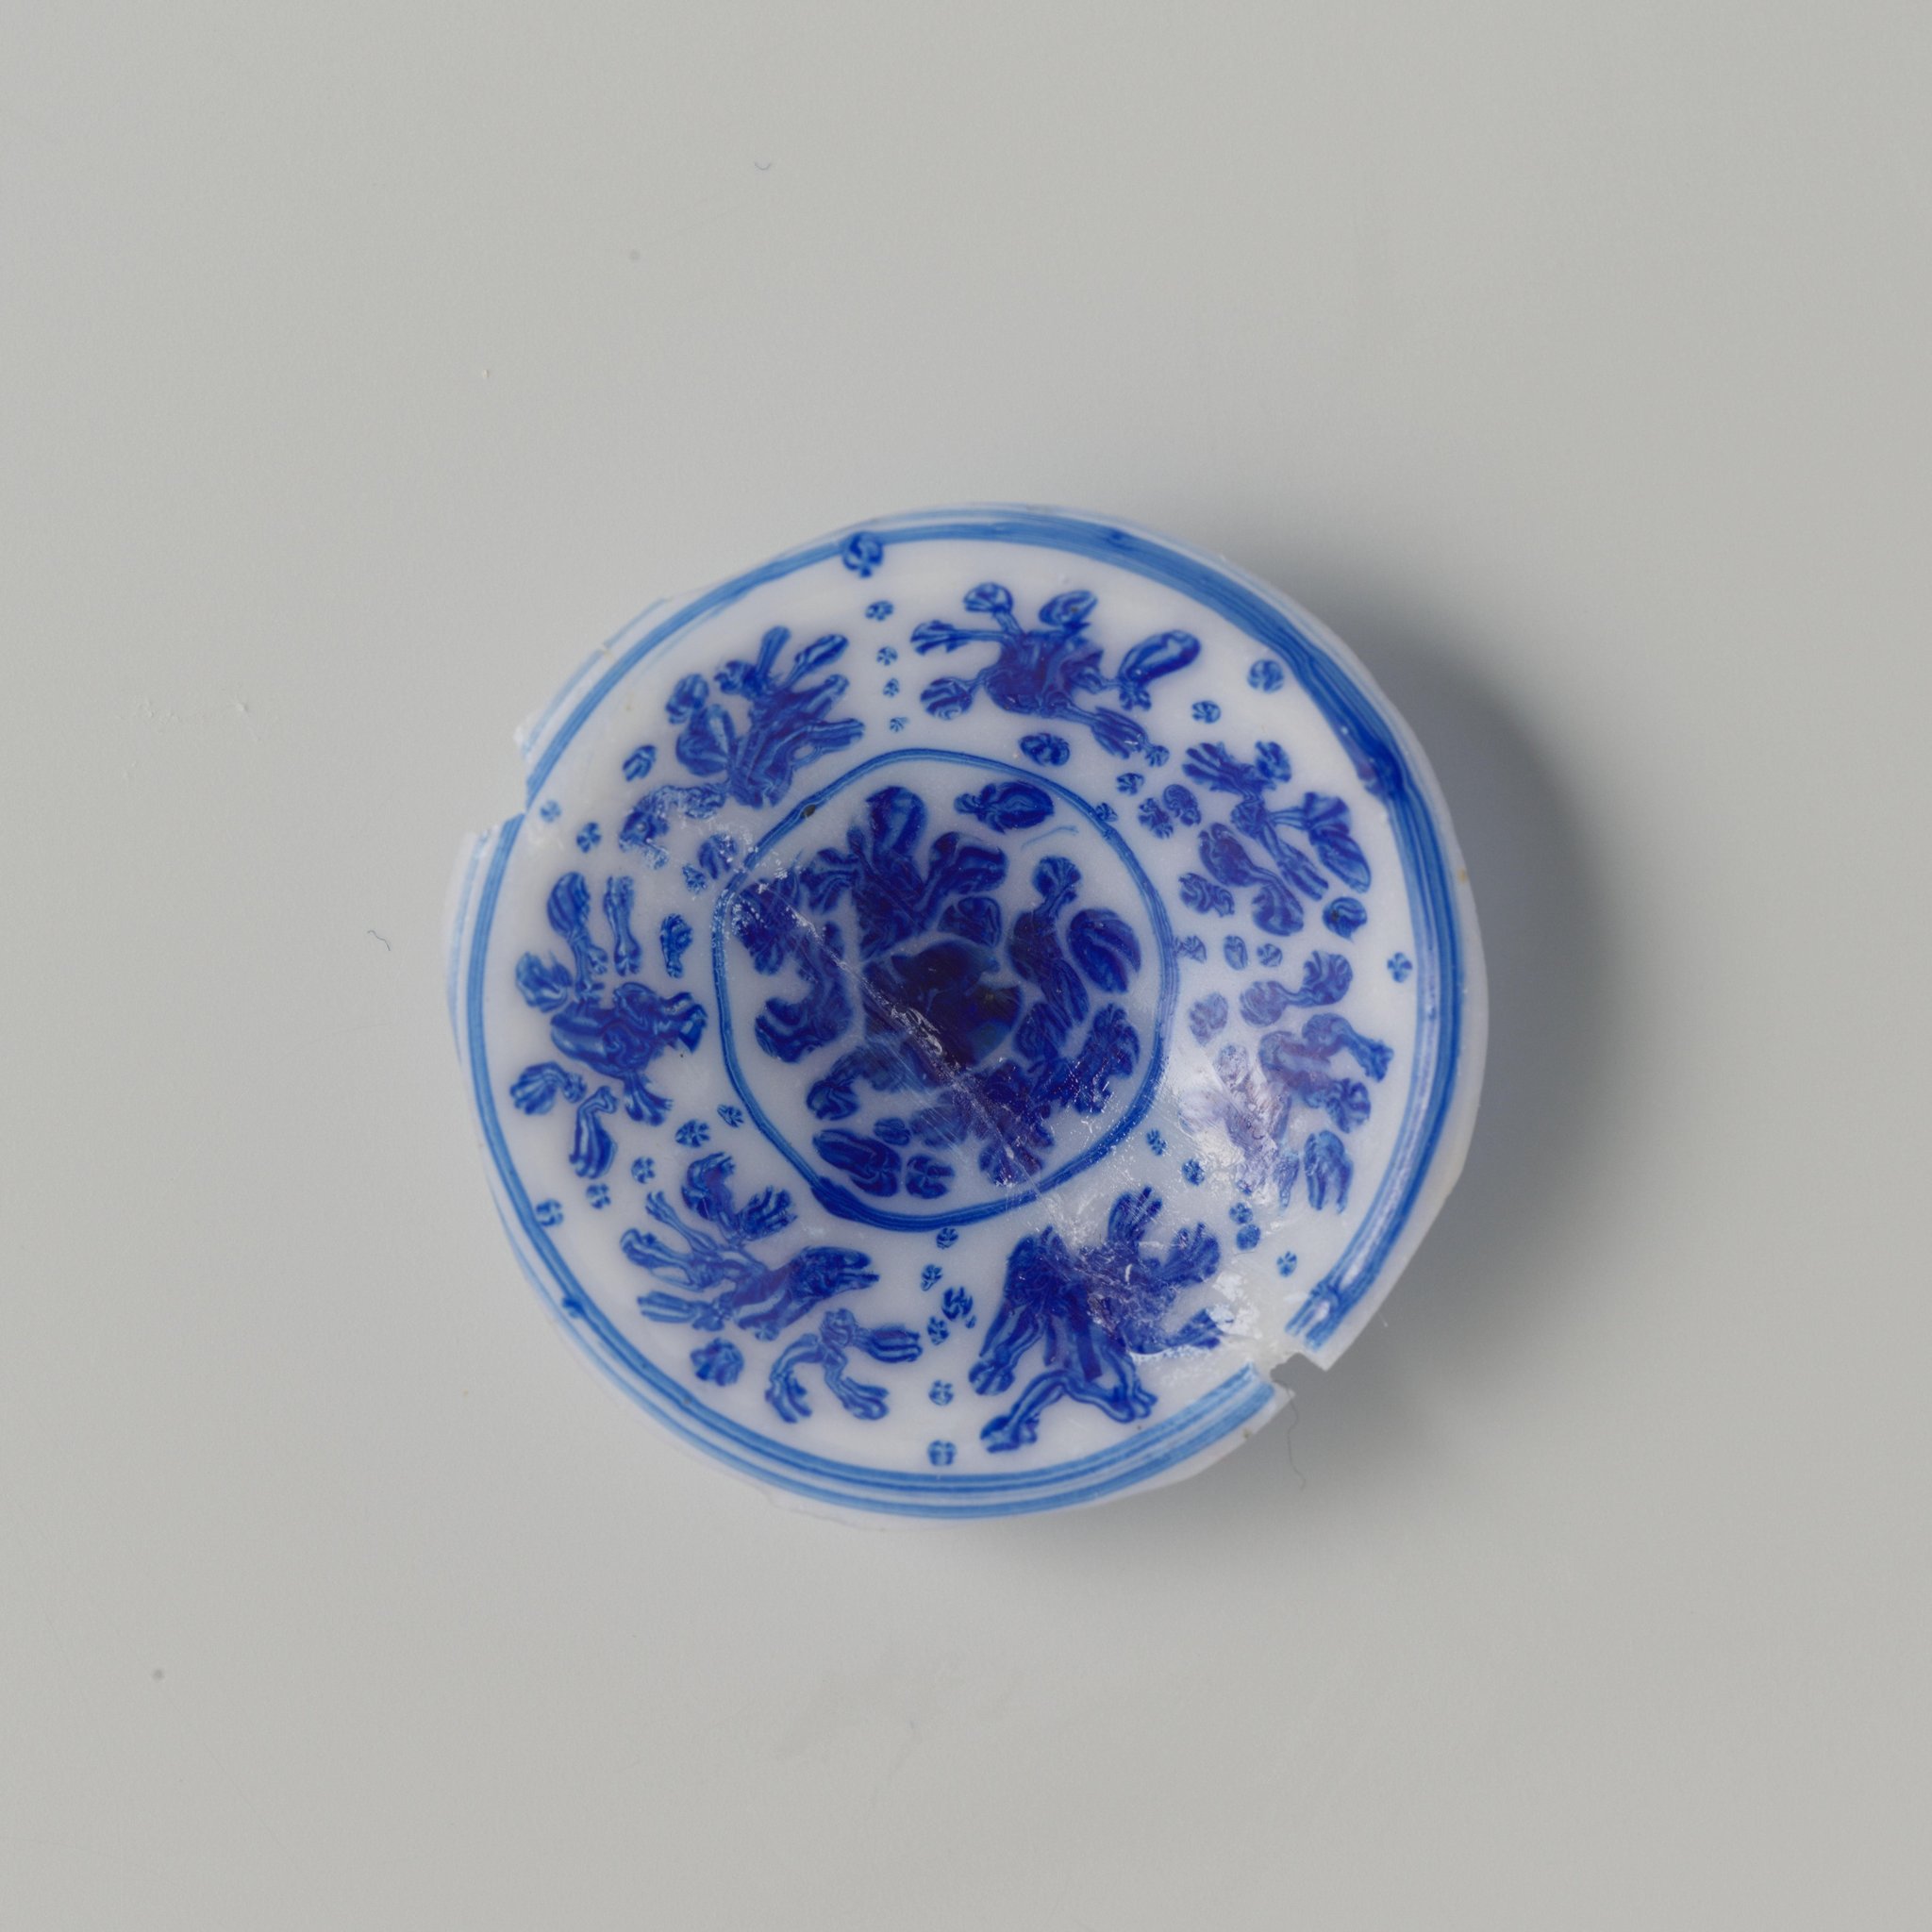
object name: platter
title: Schotel van melkglas met blauwe emailverf beschildering, imitatie Chinees porselein; bloemmotieven in vakken in Kraakporselein stijl; dubbelwandig met gladde rand.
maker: Anonymous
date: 1675-1710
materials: glass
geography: amsterdam